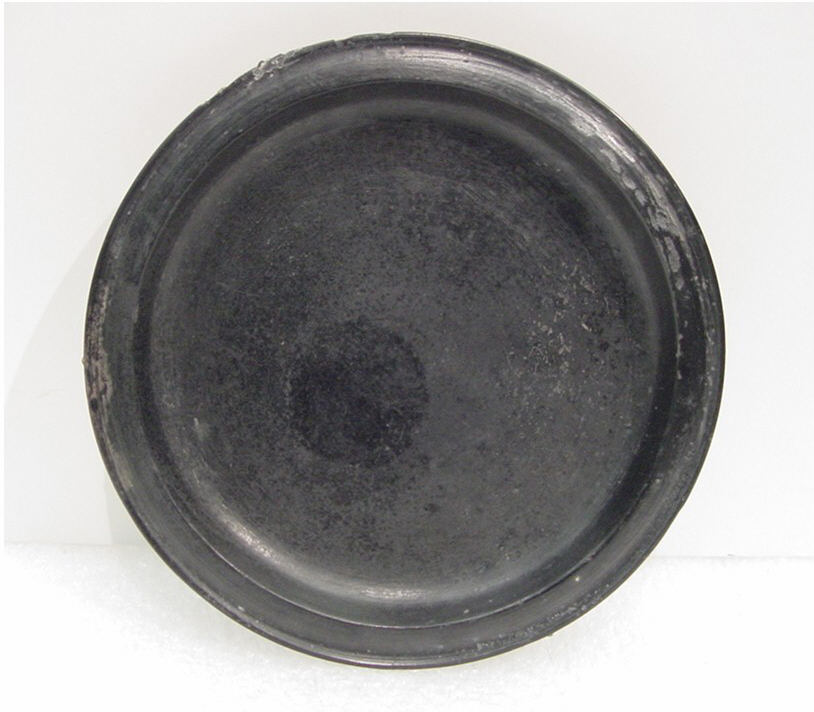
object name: dish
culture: chinese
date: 1301-1400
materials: stoneware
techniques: glazing